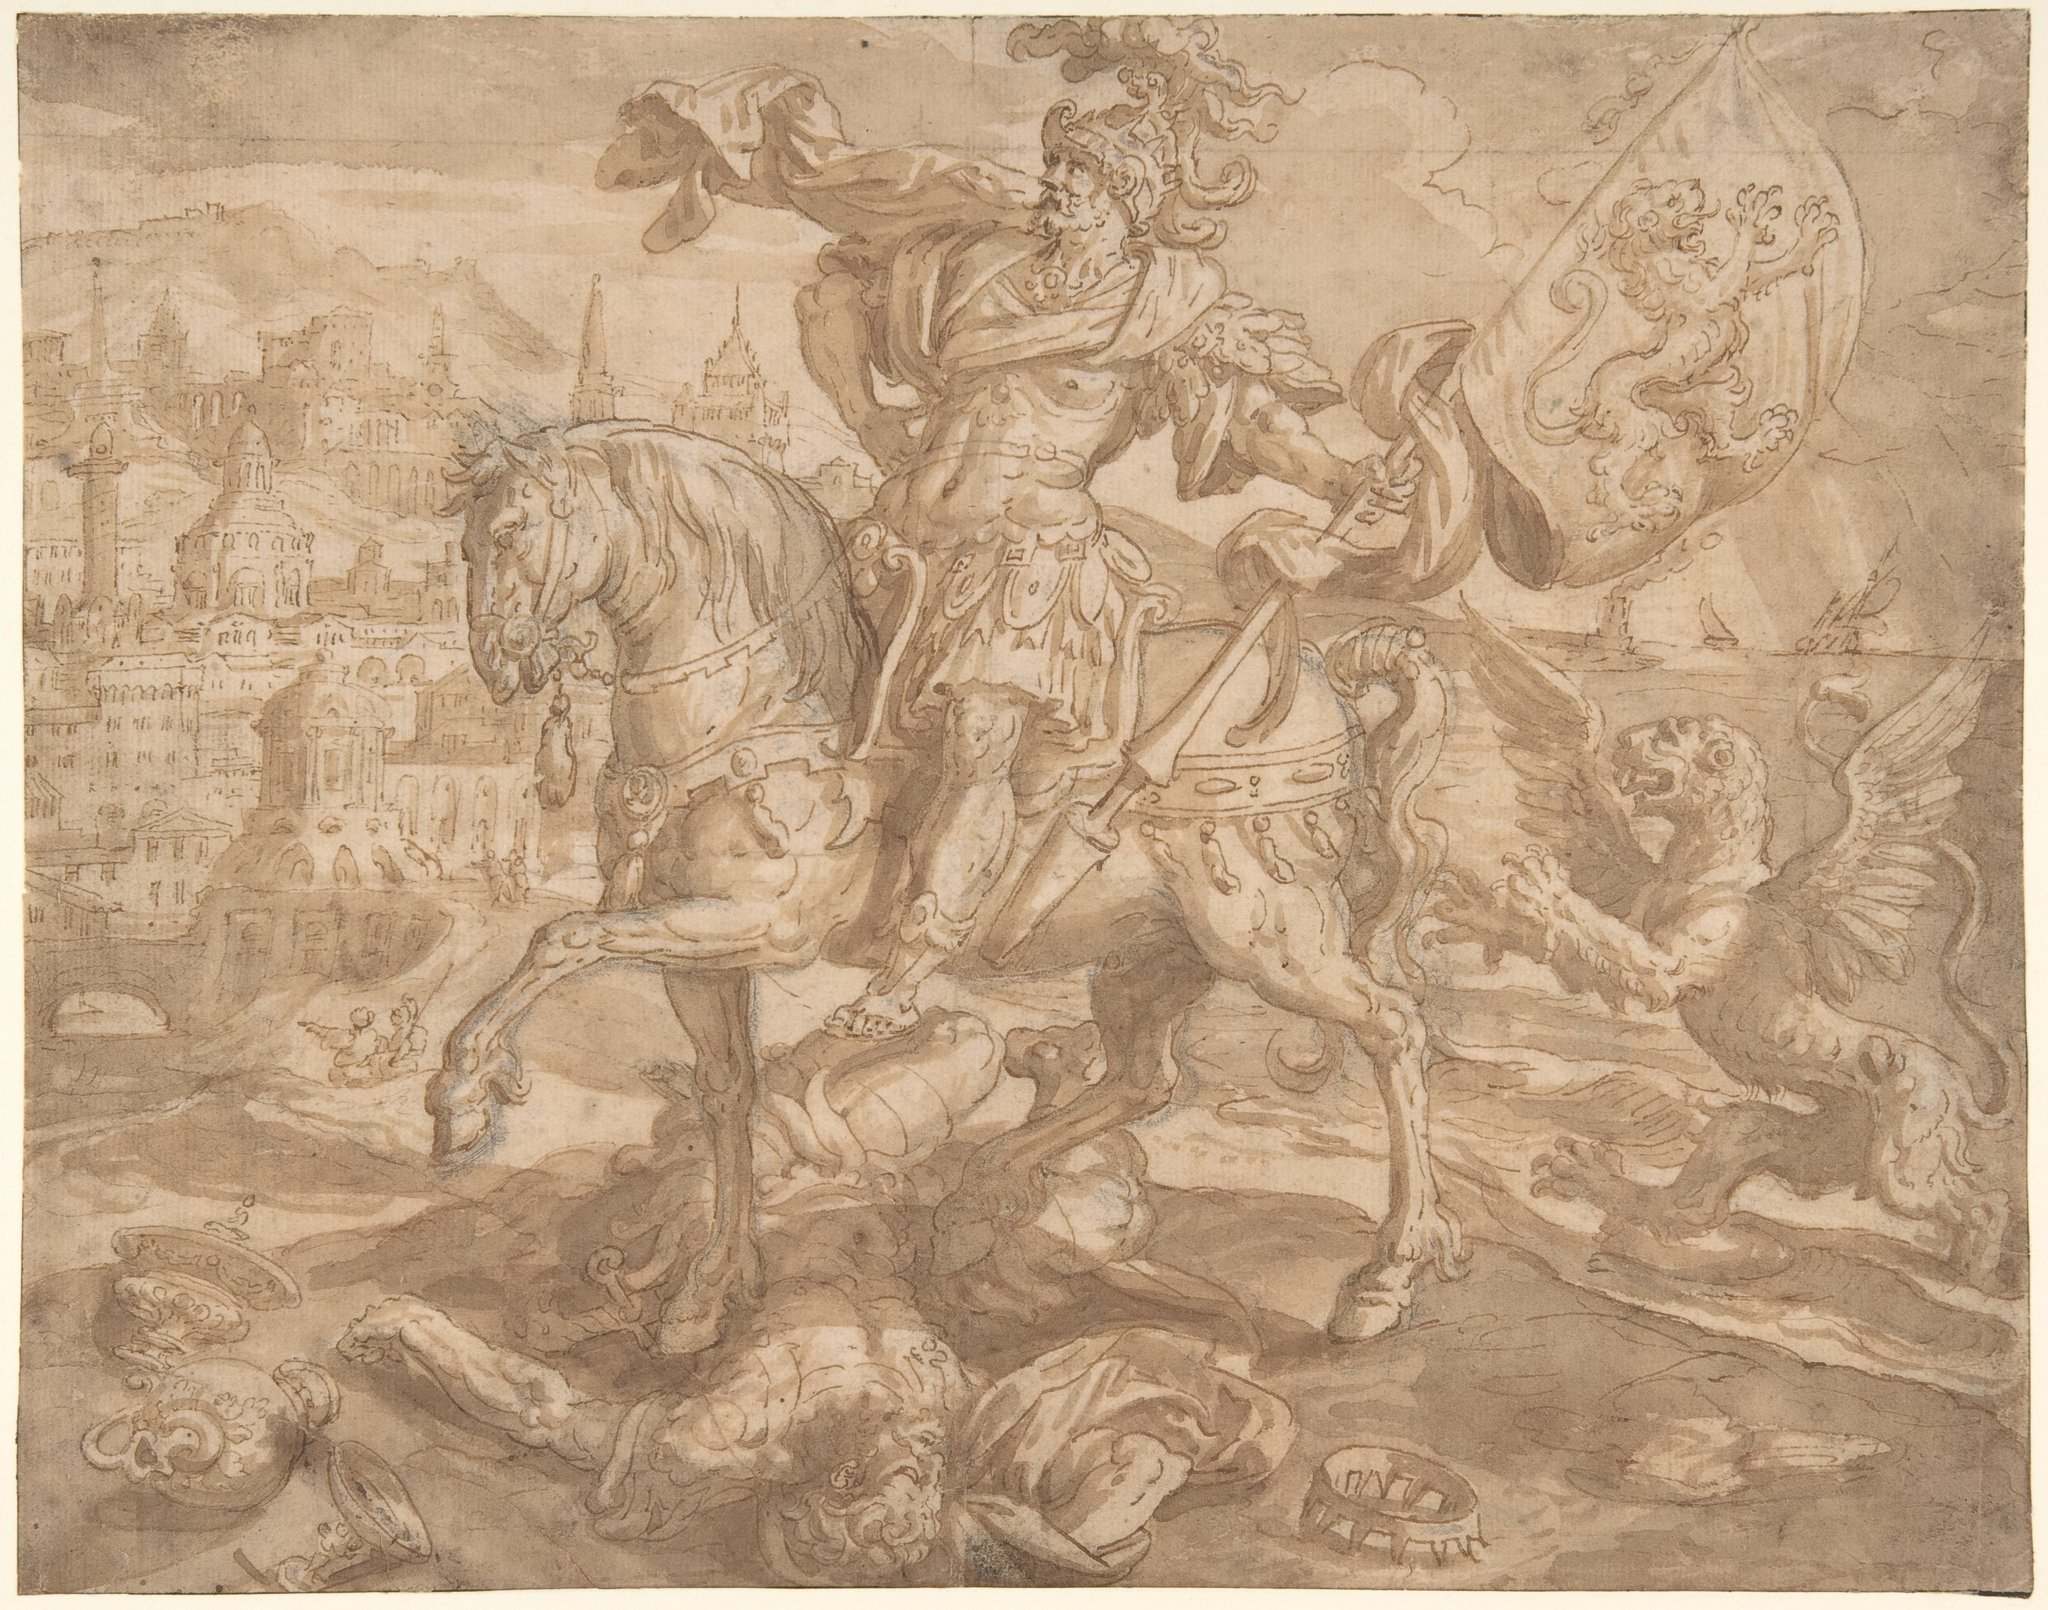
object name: drawing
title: Emperor Ninus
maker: maerten de vos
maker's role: artist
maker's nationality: netherlandish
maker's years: 1532-1603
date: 1534-1633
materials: chalk, ink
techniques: brush, pen, wash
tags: men,horses,flags